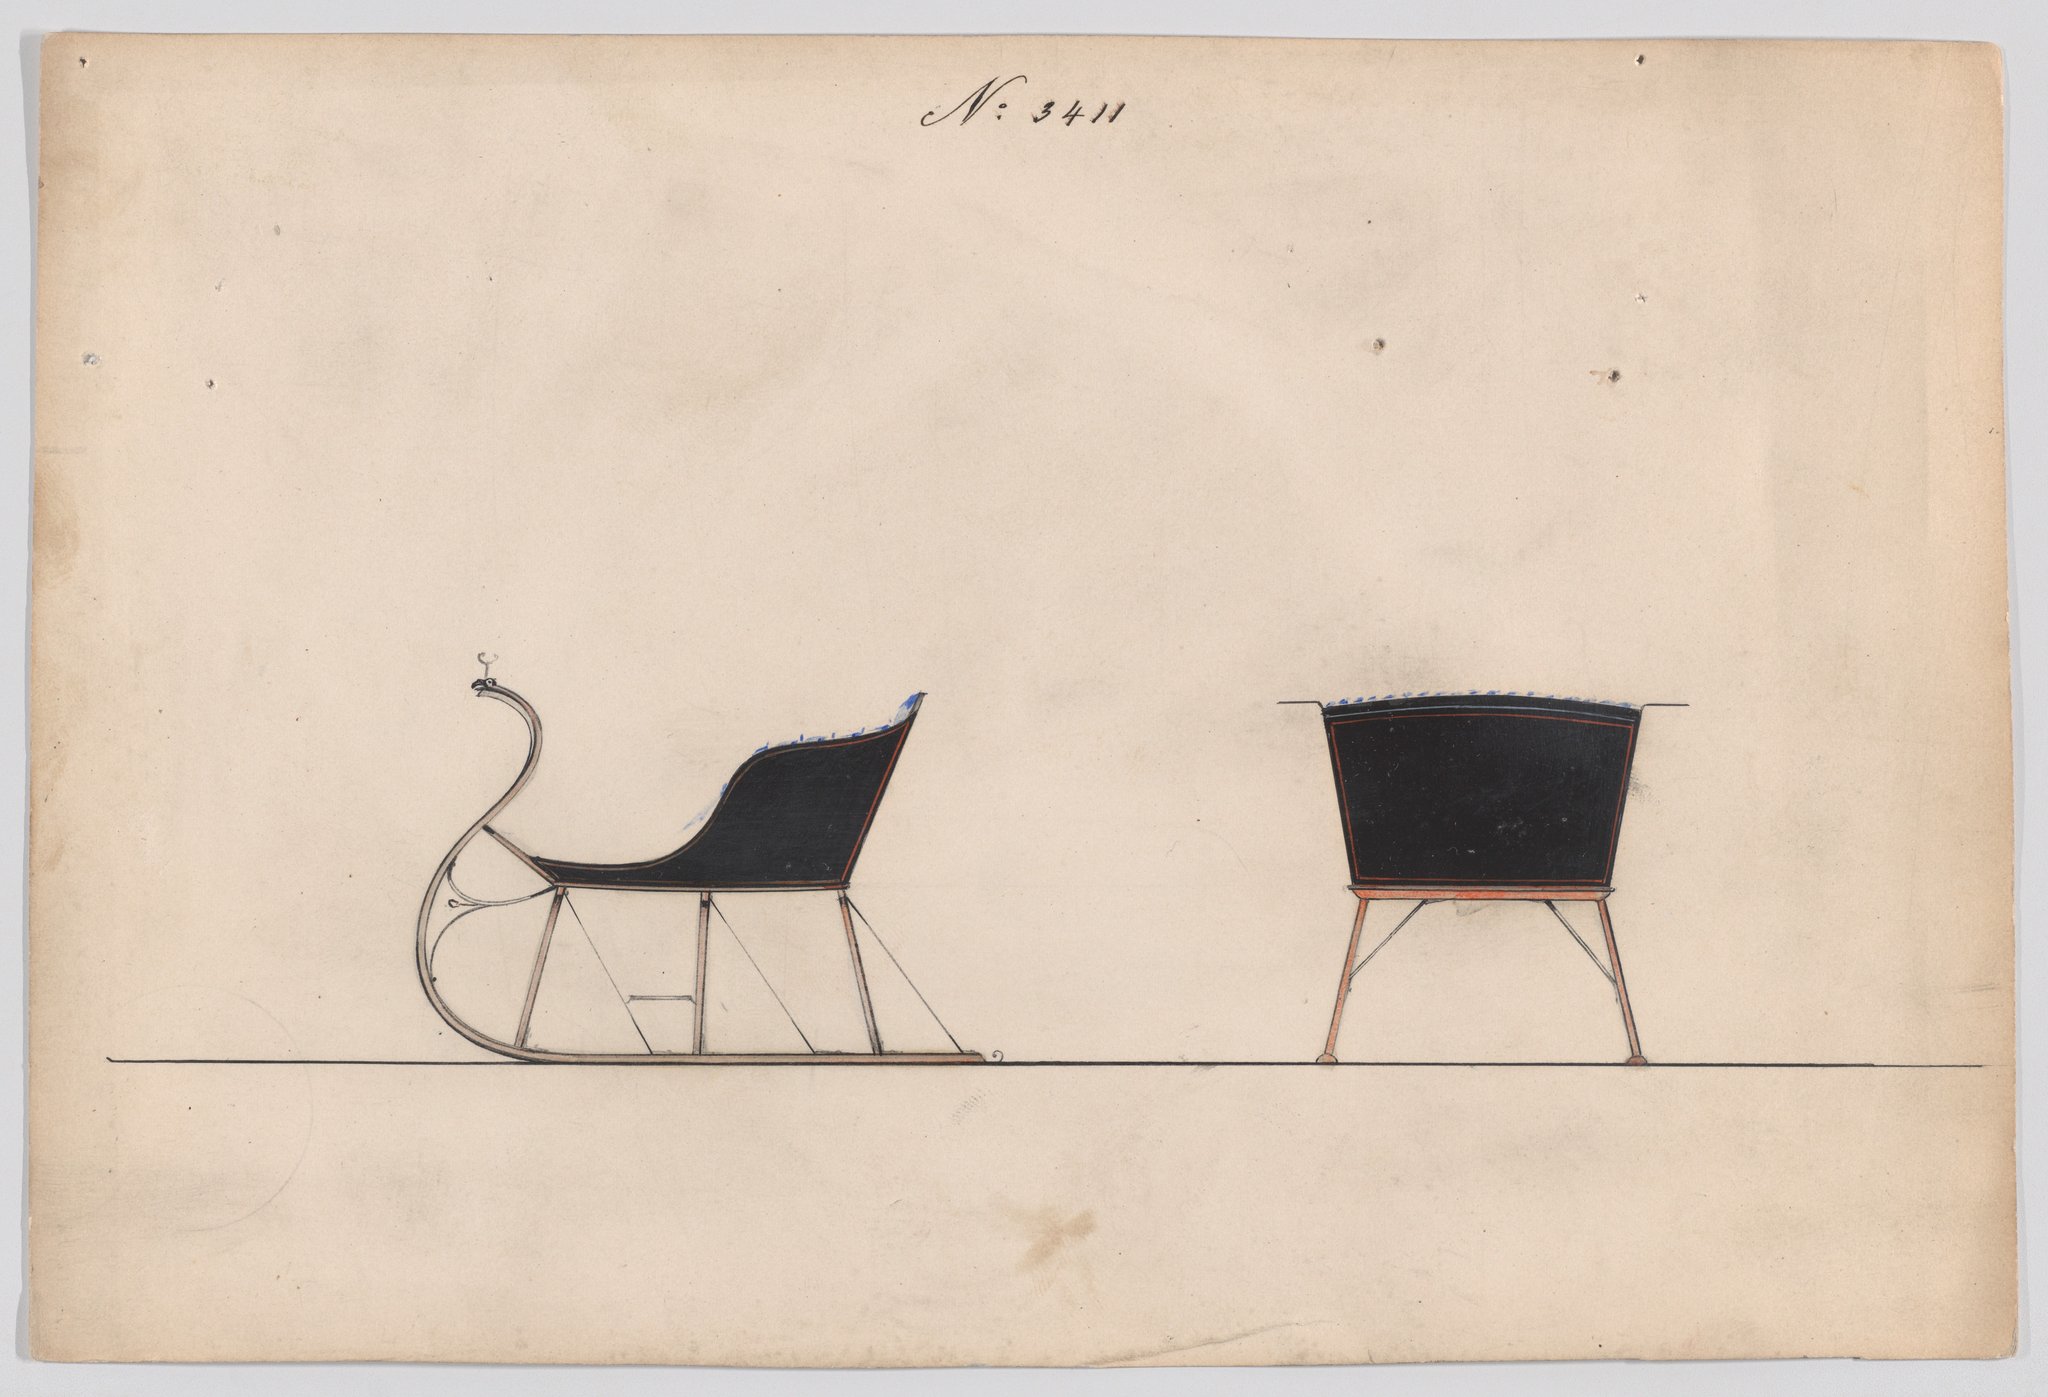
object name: drawing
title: Cutter #3411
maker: brewster & co.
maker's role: manufacturer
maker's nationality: american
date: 1878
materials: gouache, gum arabic, watercolor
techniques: pen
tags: sleighs